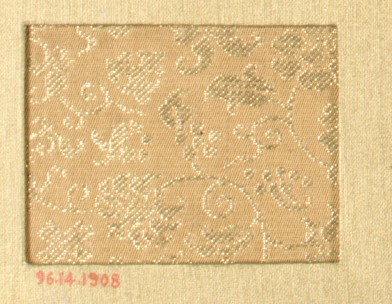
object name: piece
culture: japanese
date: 1701-1900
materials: silk